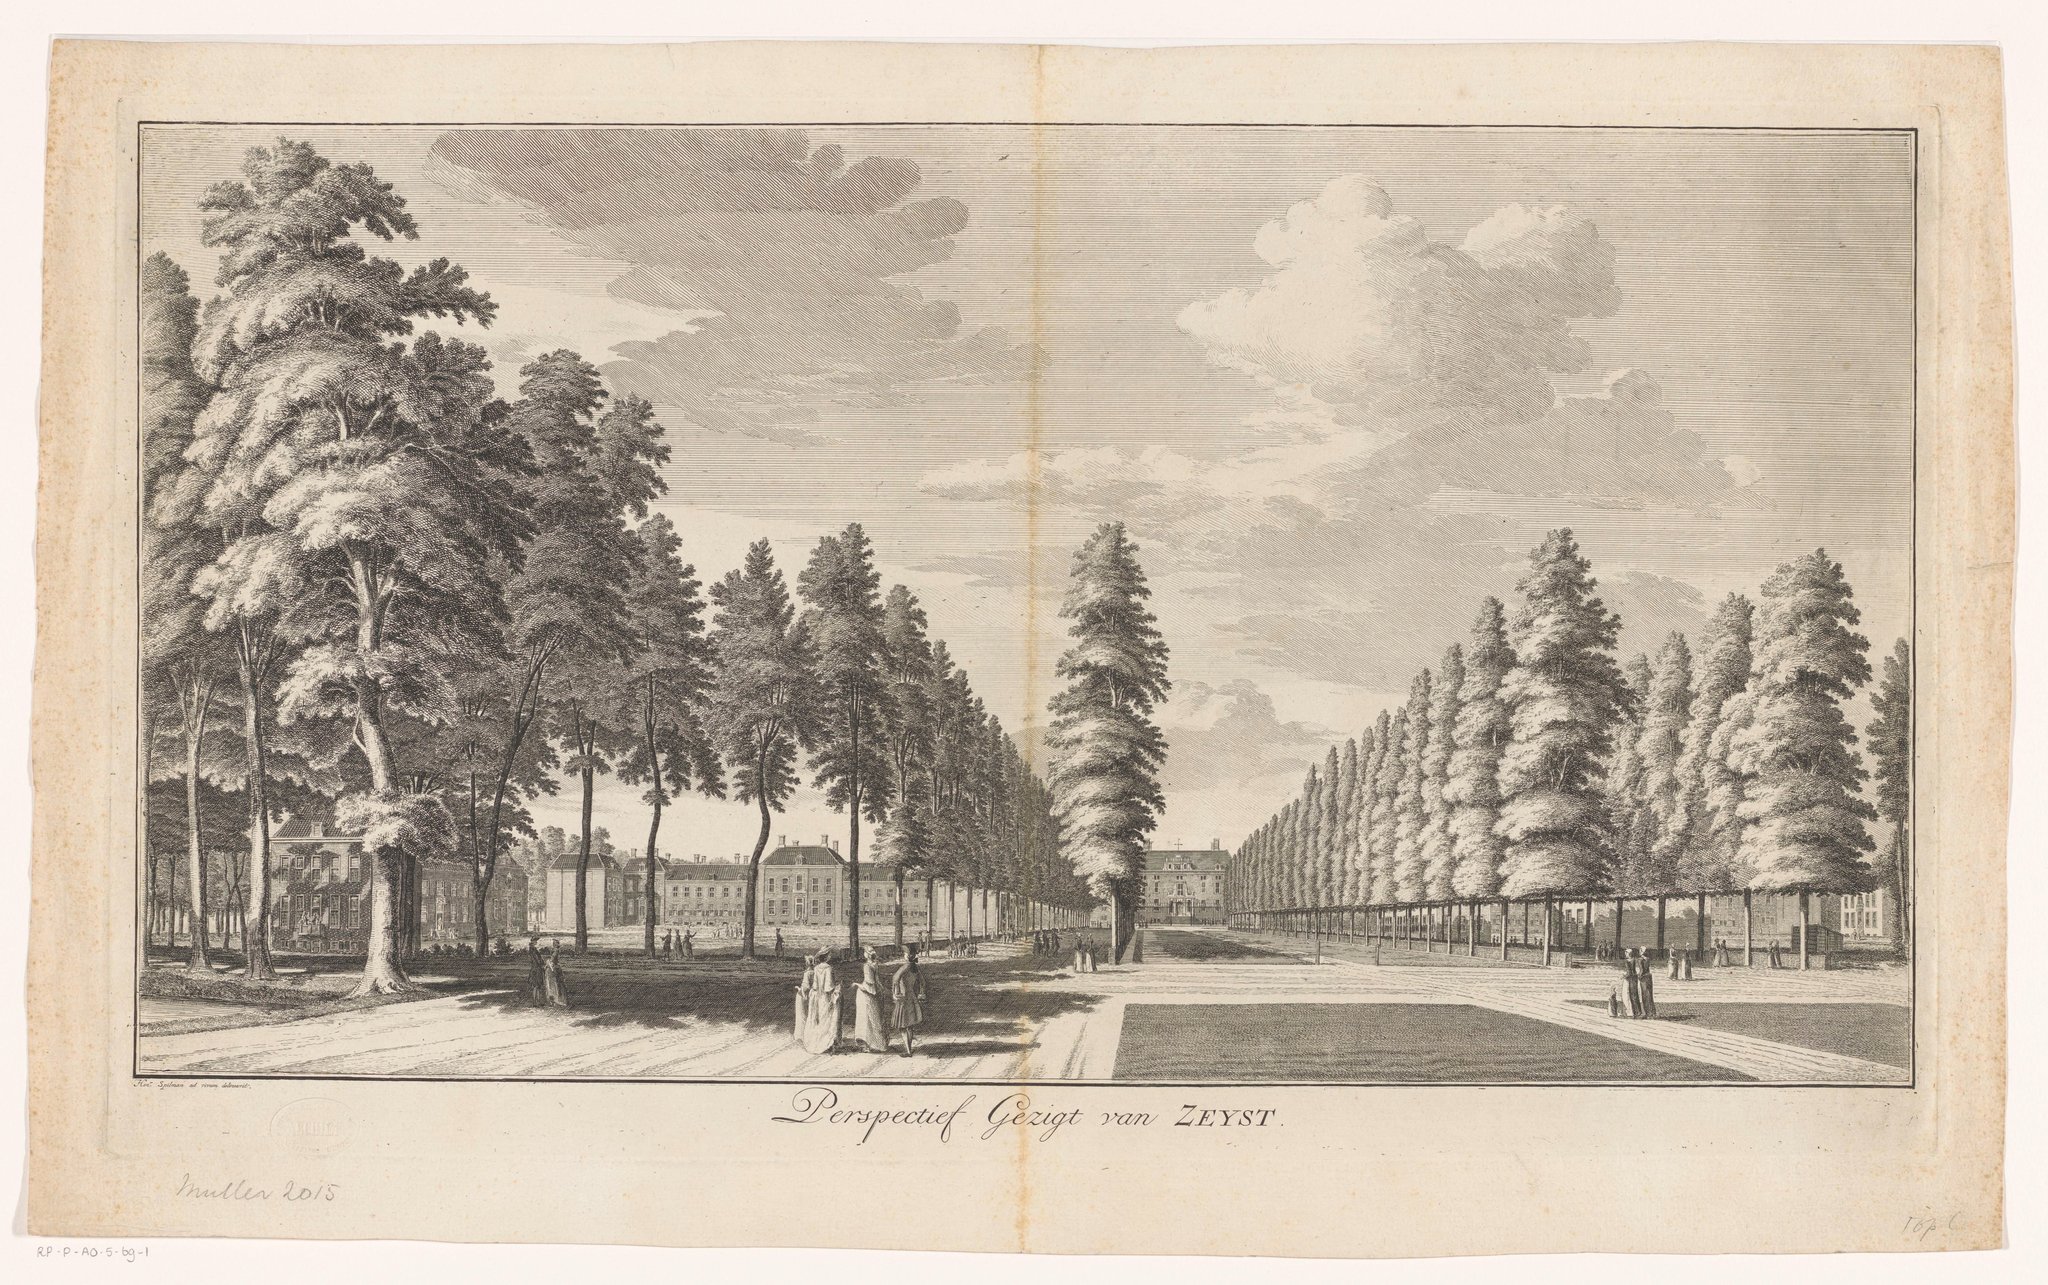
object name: print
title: Gezicht in de Nassau Odijklaan te Zeist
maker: hendrik spilman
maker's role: draughtsman, painter, print maker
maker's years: 1721-1784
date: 1742-1784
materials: paper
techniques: etching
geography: haarlem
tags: lane, alley, zeist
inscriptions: check stamp: ‘Archief Ministerie van Oorlog Afdeeling Genie’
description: Gezicht in de Nassau Odijklaan te Zeist in de richting van Slot Zeist met links het Broederplein en rechts het Zusterplein.